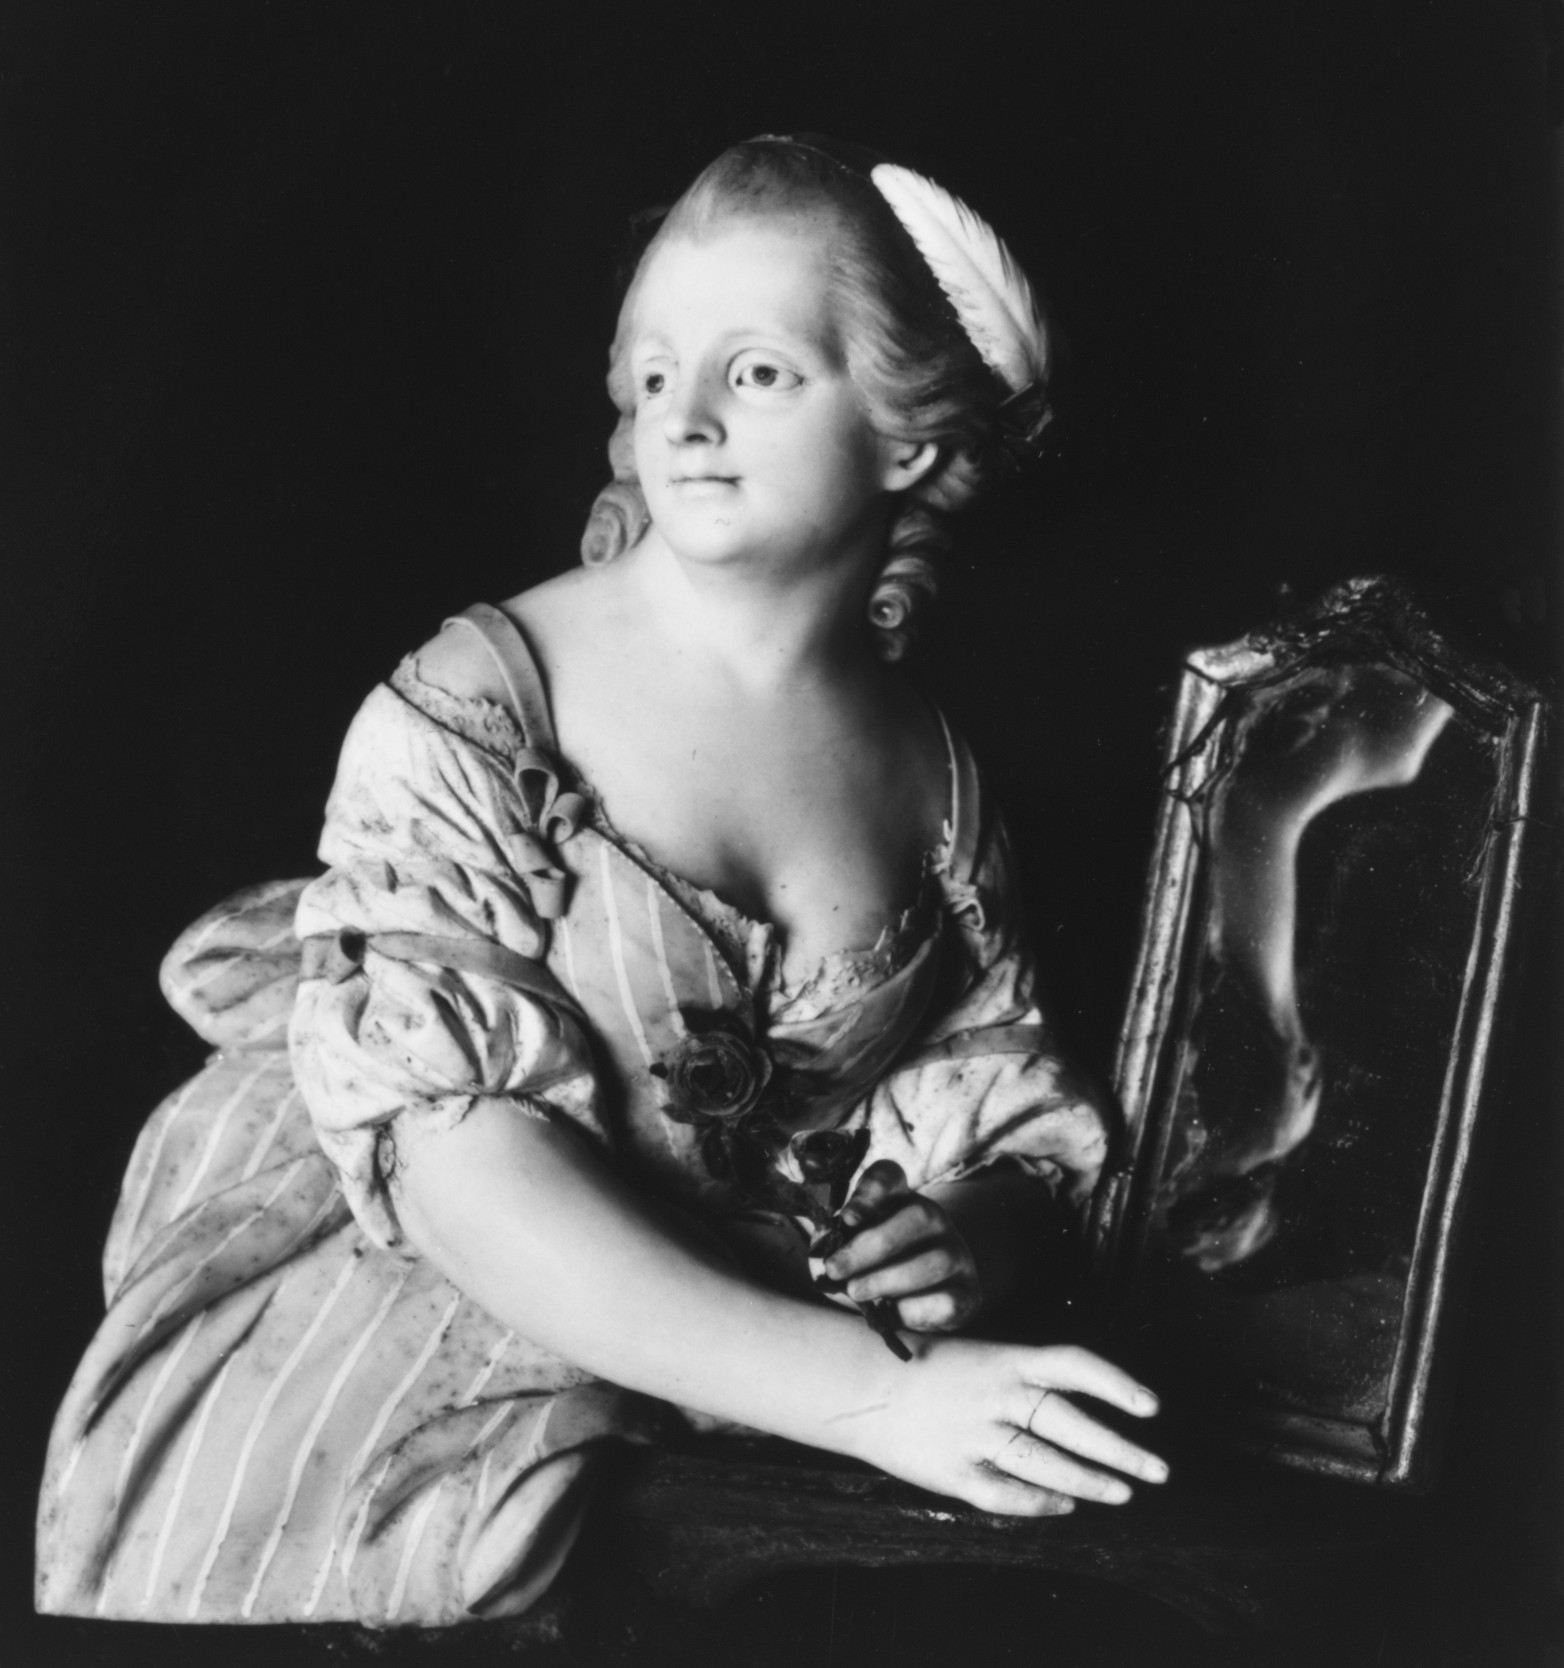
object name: miniature sculpture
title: Lady with a mirror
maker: bernhard caspar hardy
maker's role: artist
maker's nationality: german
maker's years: 1726-1819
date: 1767-1833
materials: wax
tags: women,mirrors